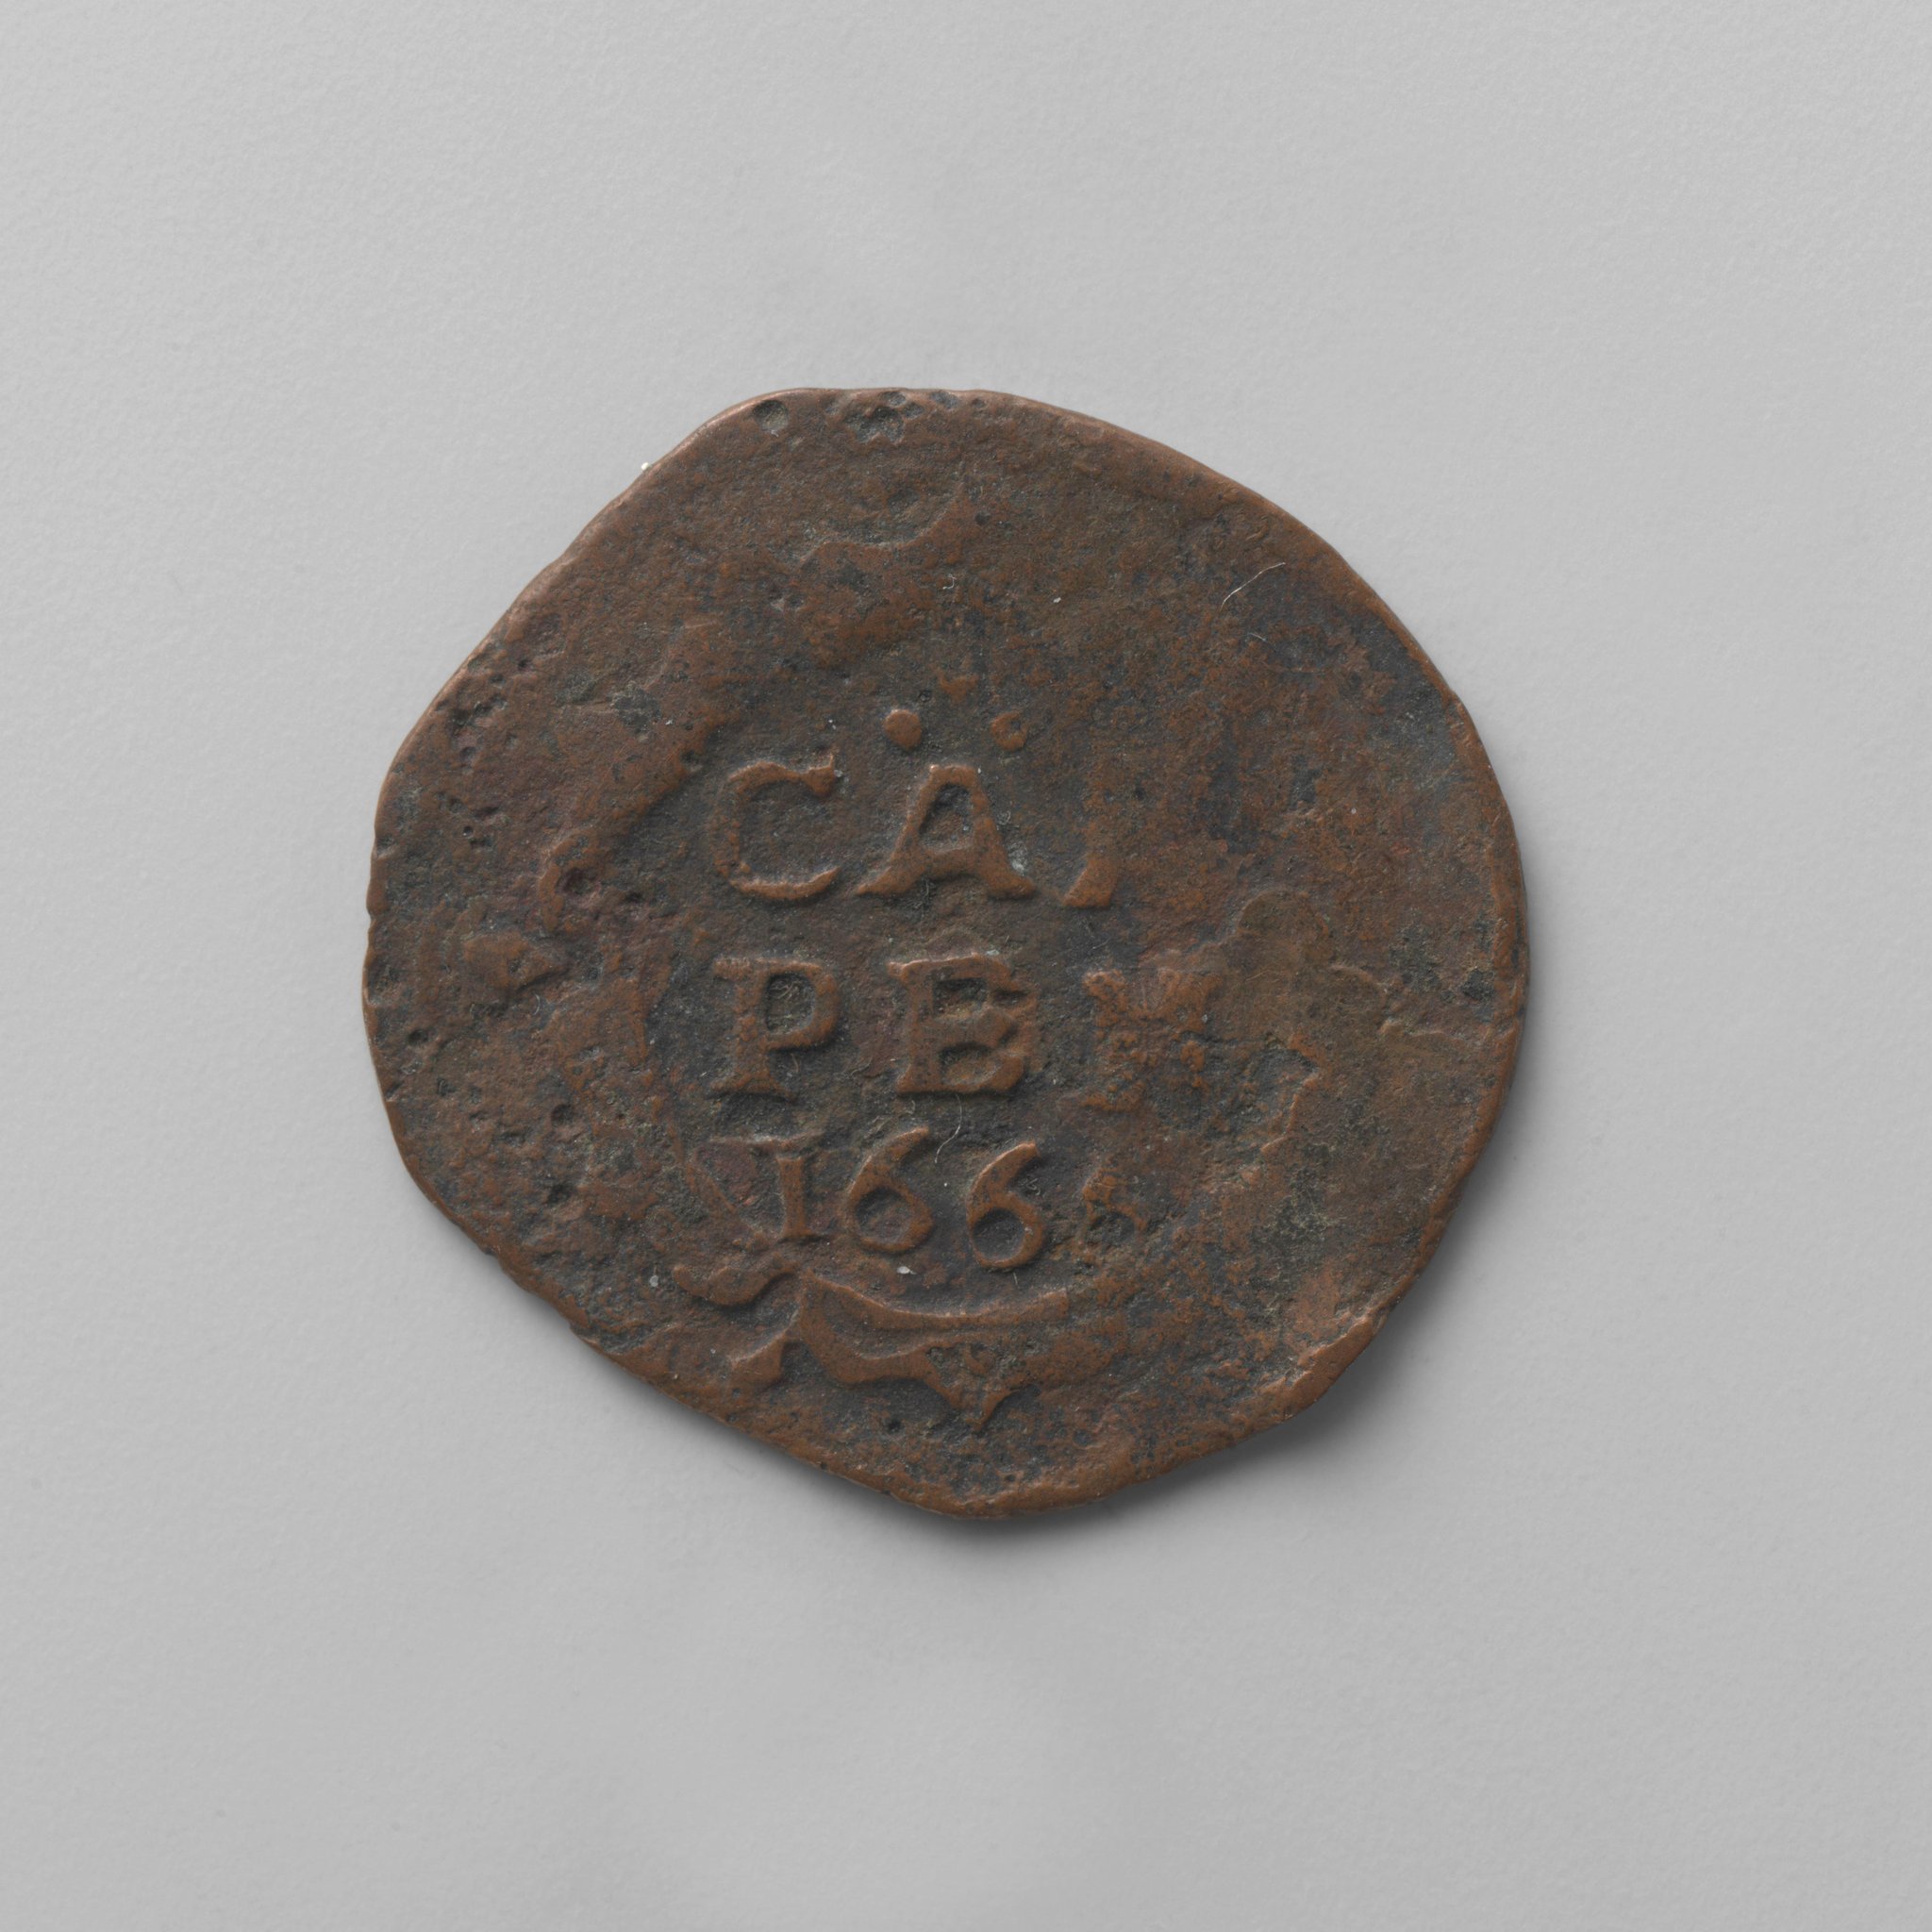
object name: coin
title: Kampen, duit, 1666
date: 1666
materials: copper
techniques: striking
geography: kampen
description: Koperen munt. Voorzijde: binnen een bladerkrans stadswapen. Keerzijde: binnen een versierde rand tweeregelig opschrift, waaronder jaartal.